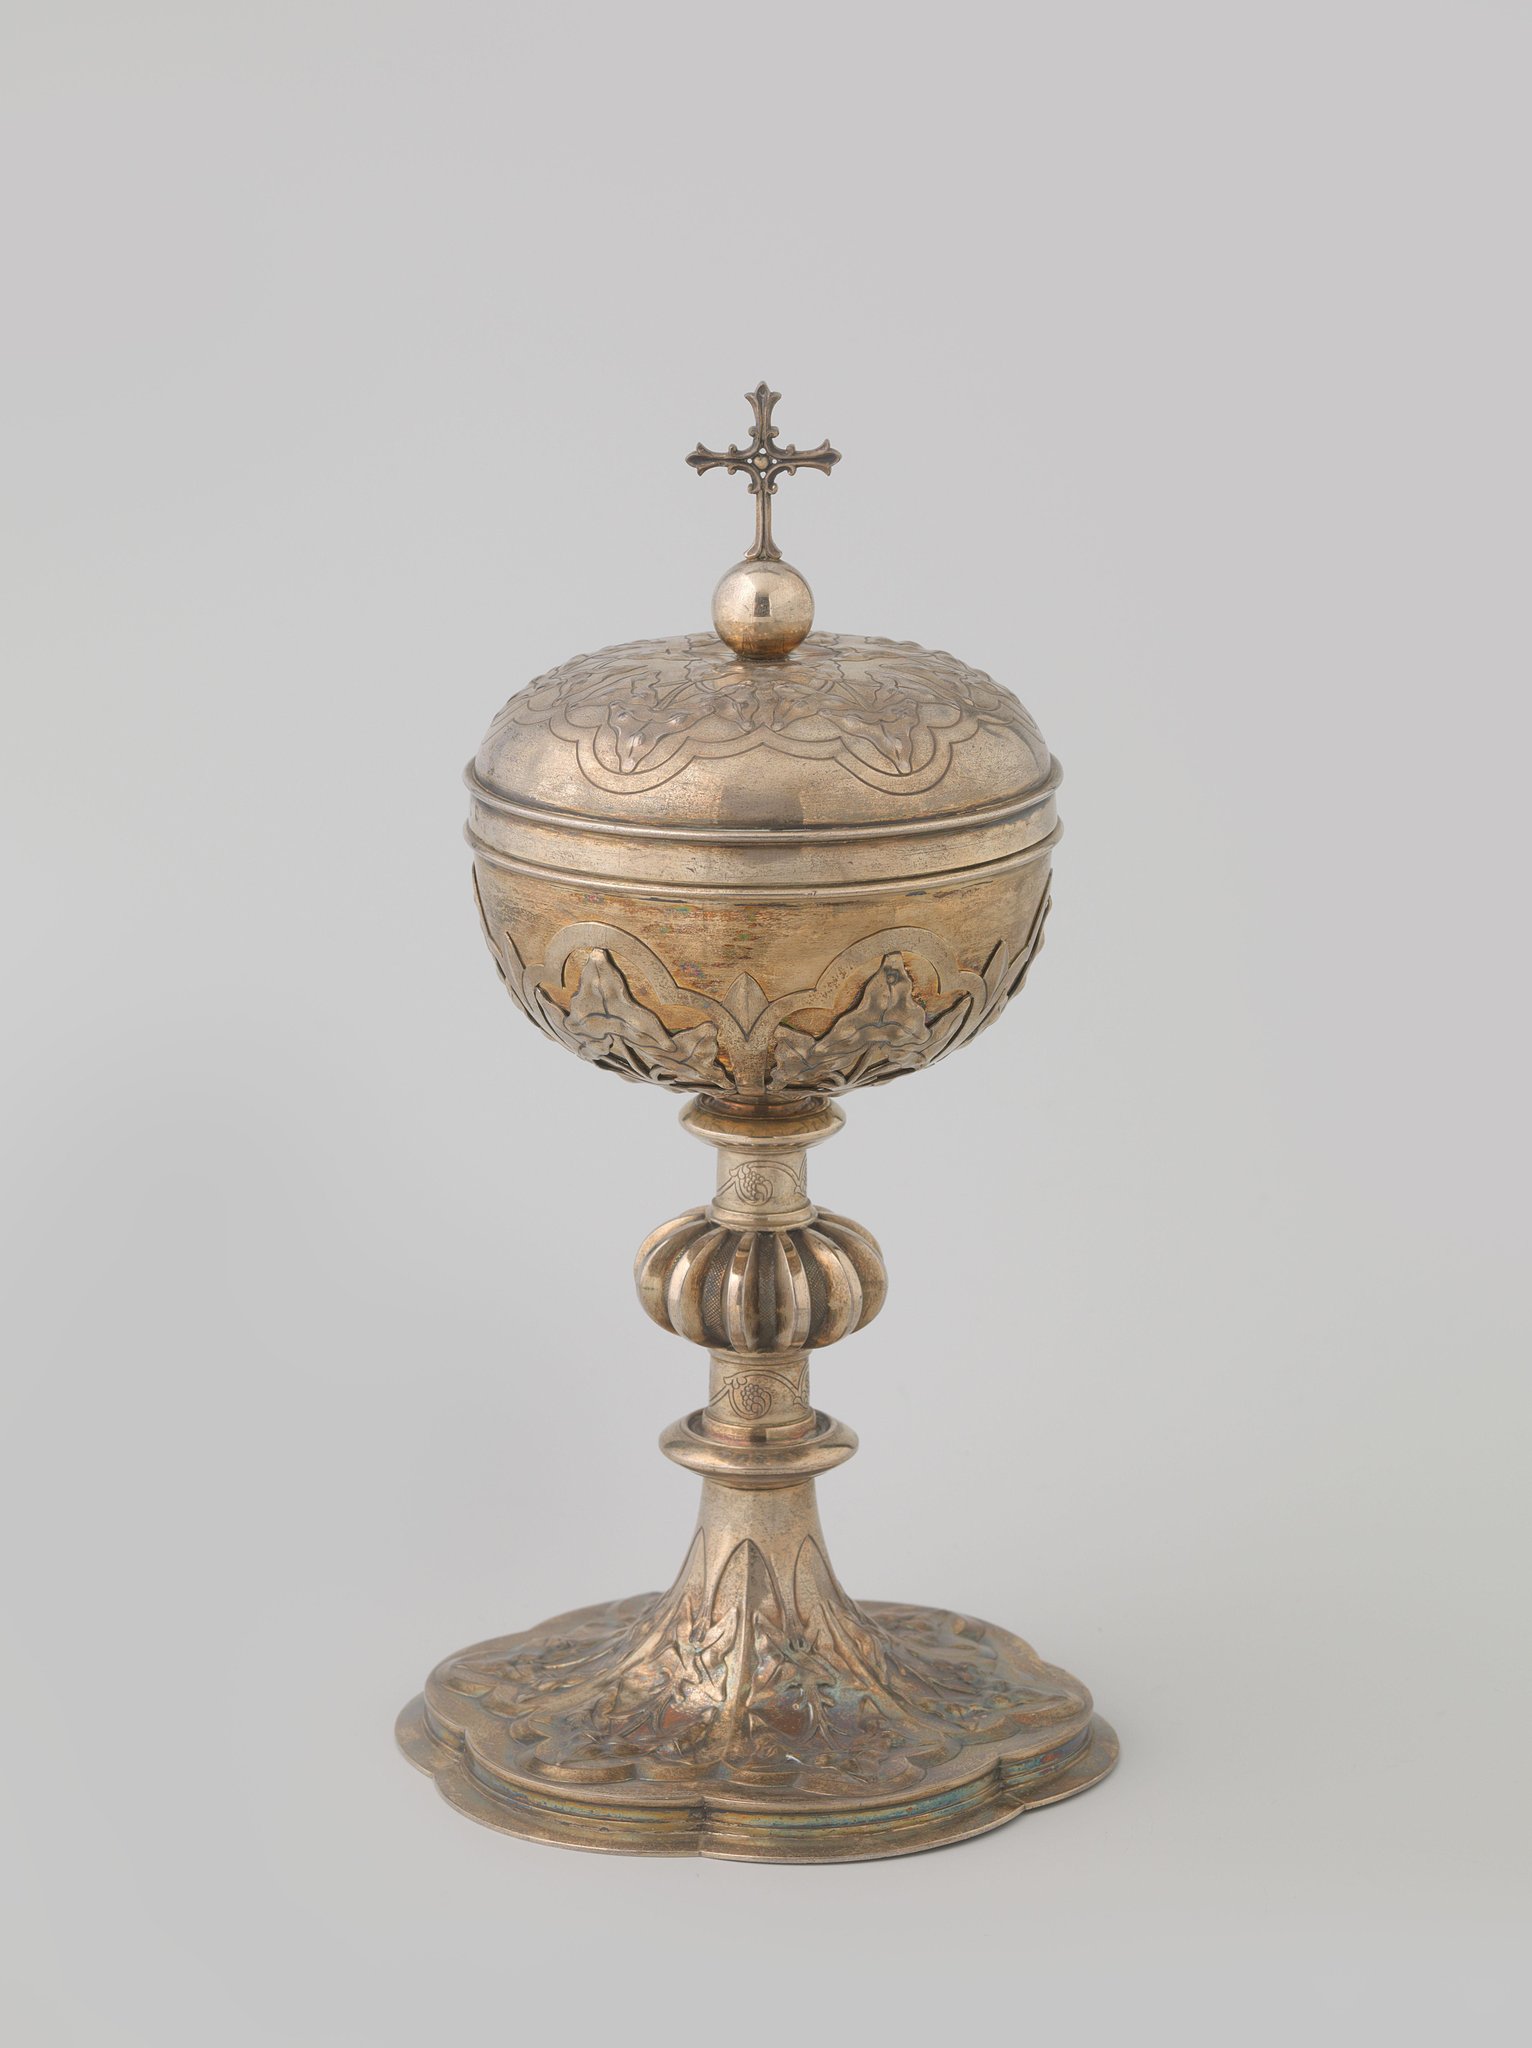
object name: ciborium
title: Ciborie versierd met bladmotieven in reliëf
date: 1860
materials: silver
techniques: gilding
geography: paris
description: Ciborie van verguld zilver, met zeslobbige voet. De gladde cuppa wordt omgeven door een losse opengewerkte versiering. Dezelfde versiering op het deksel dat wordt bekroond door een kruis op een gladde bol.